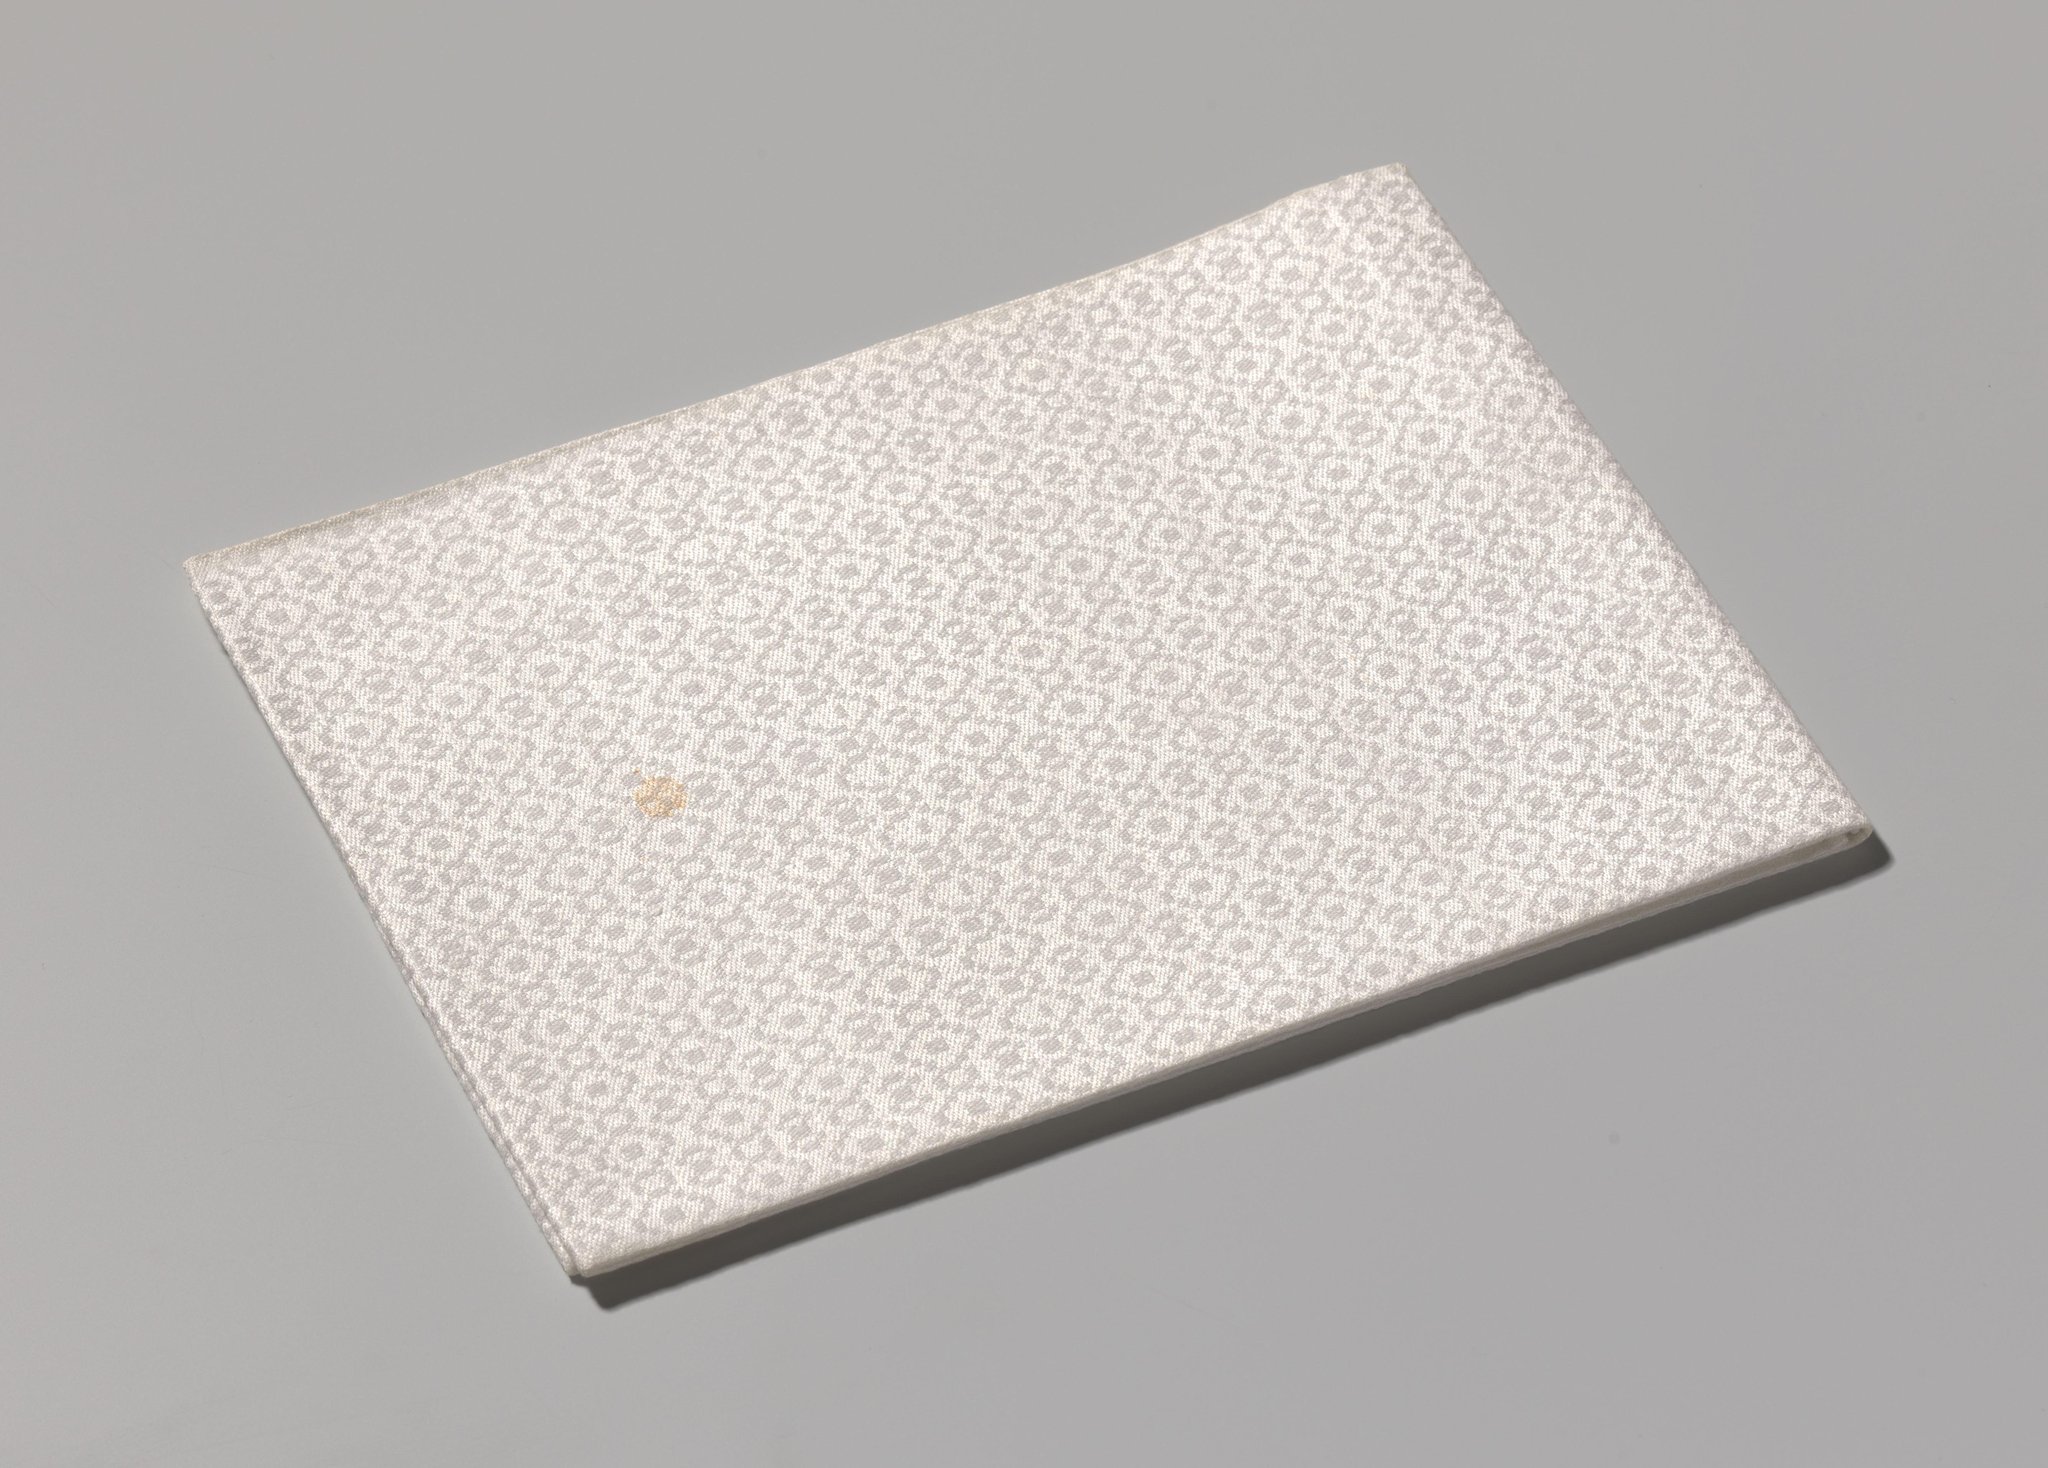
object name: napkin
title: Servet met pellenpatroon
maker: Anonymous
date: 1400-1950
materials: linen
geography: northern netherlands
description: Servet van wit linnen met pellenpatroon, merken: AVG 8 en C XL LW4.